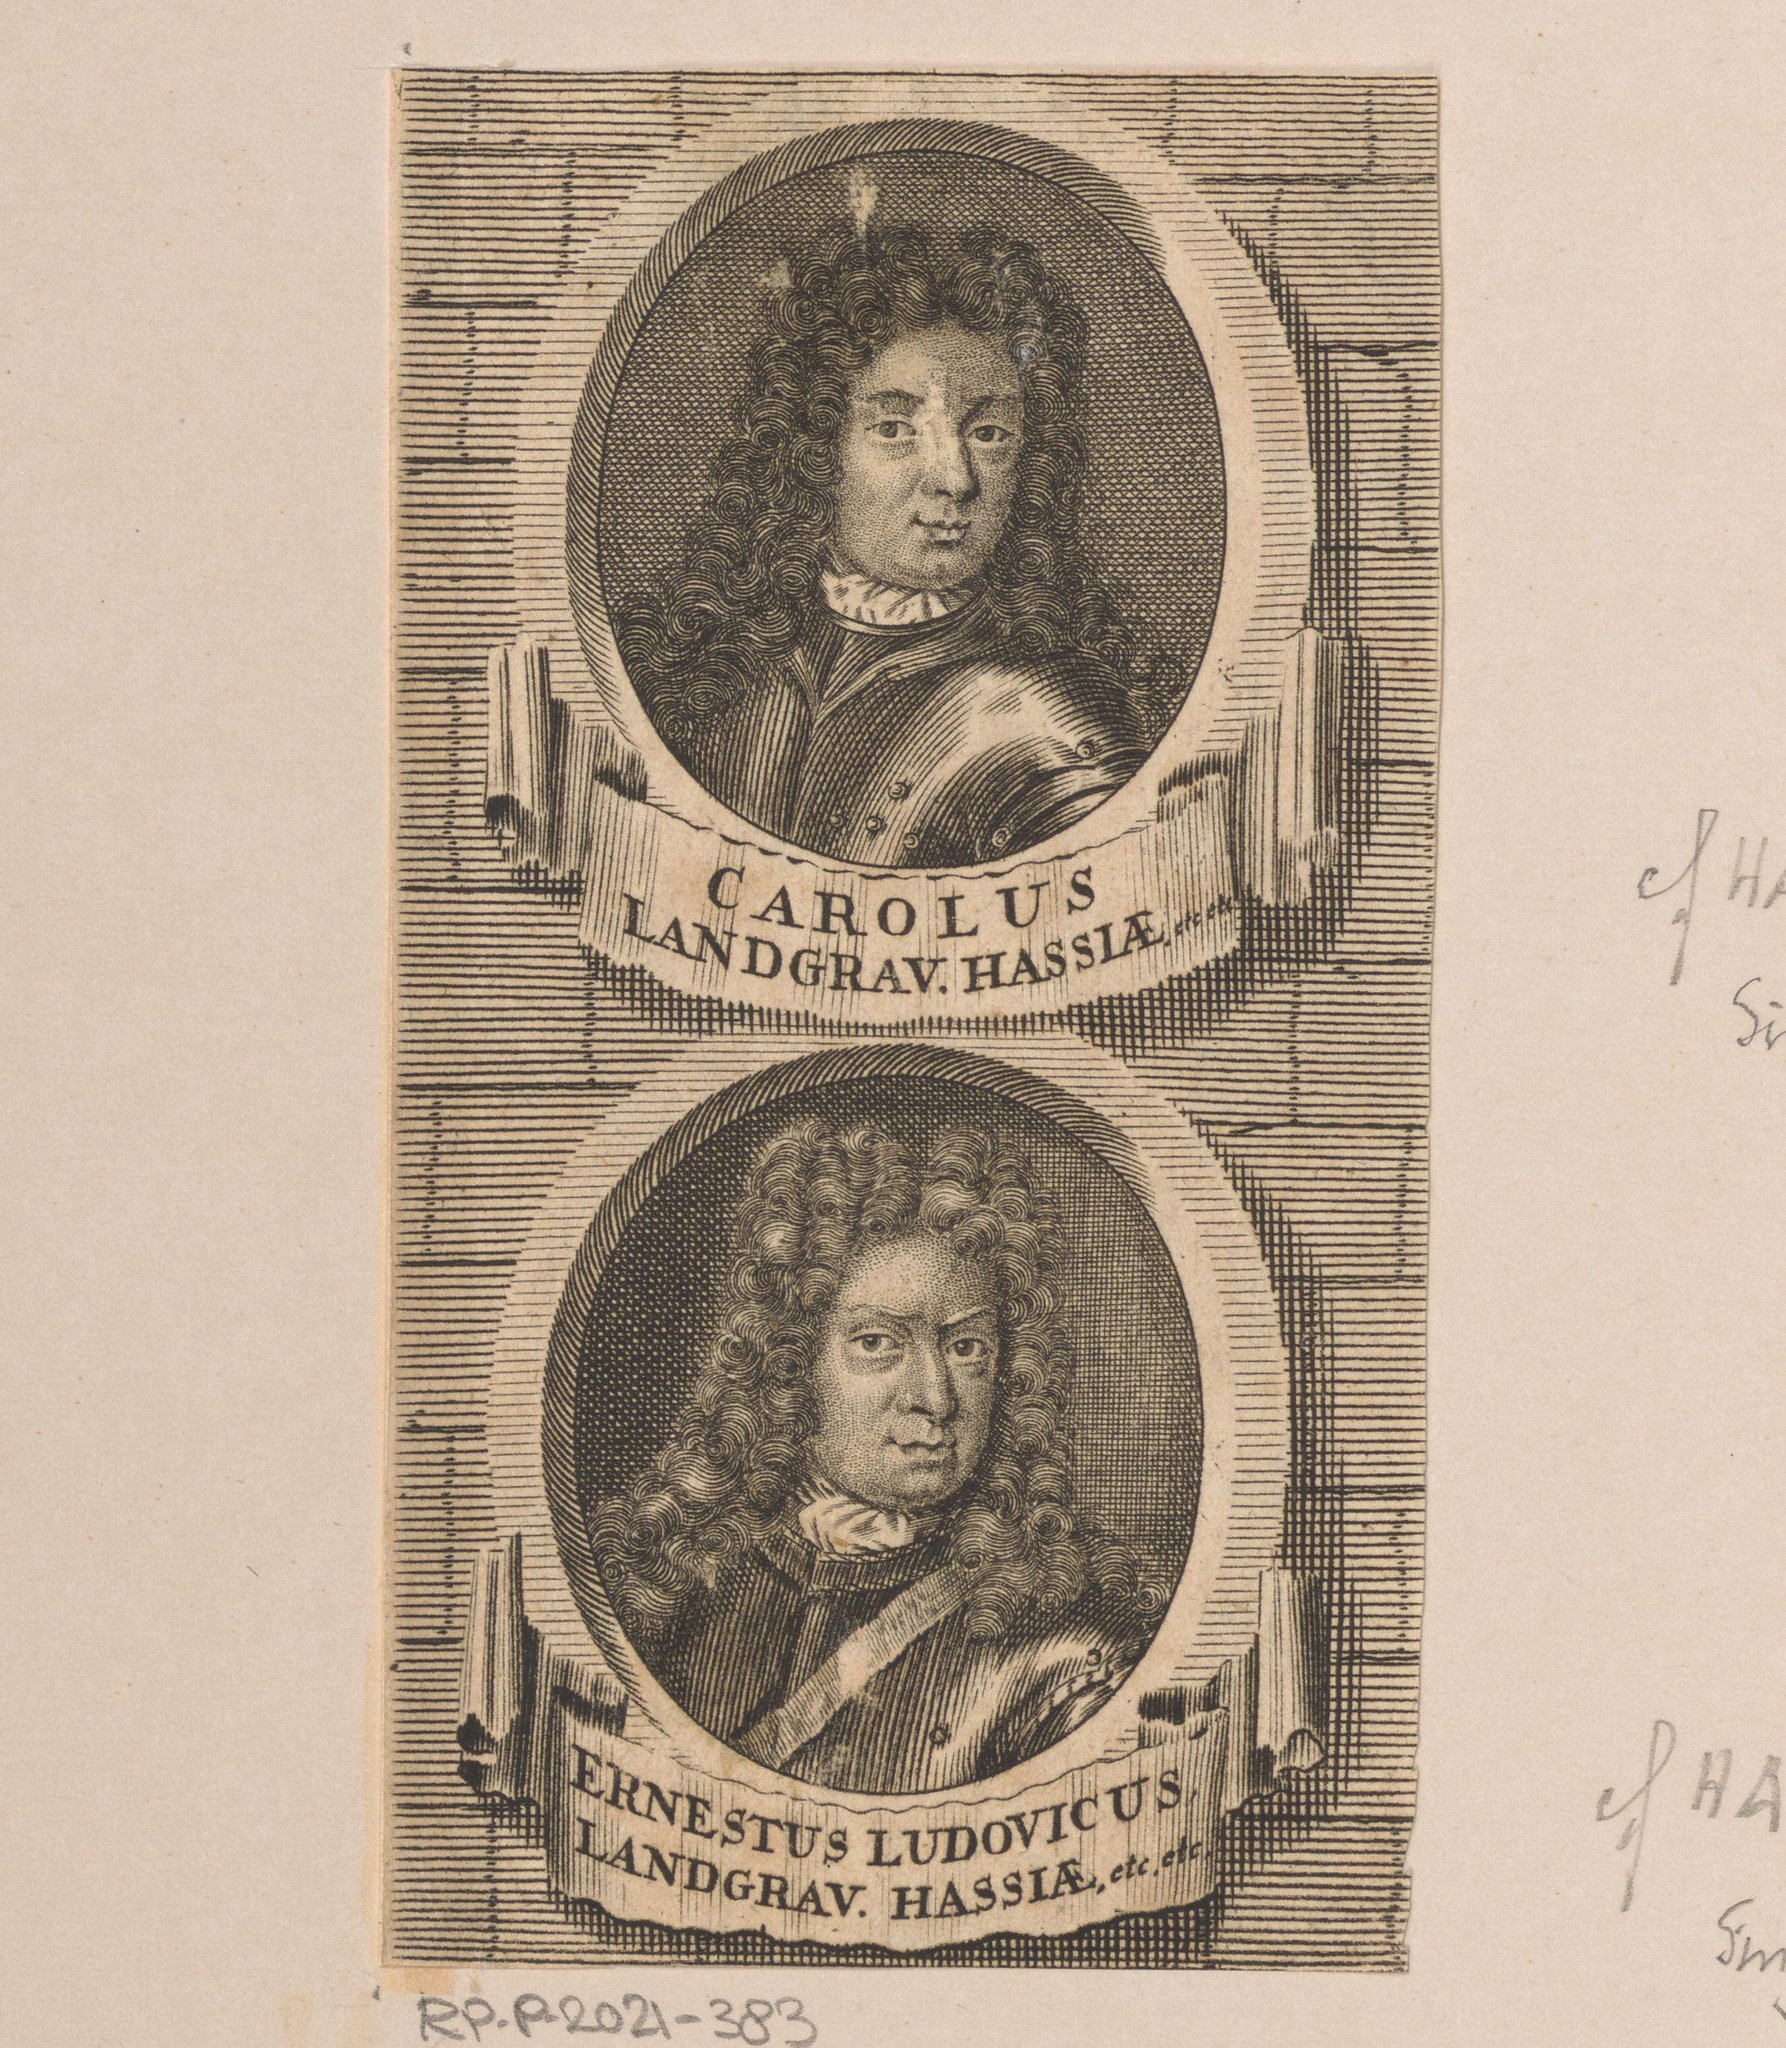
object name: print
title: Portret van Karel van Hessen-Kassel en Ernst Lodewijk van Hessen-Darmstadt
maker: Anonymous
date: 1678-1799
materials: paper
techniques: engraving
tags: historical persons, ruler, sovereign